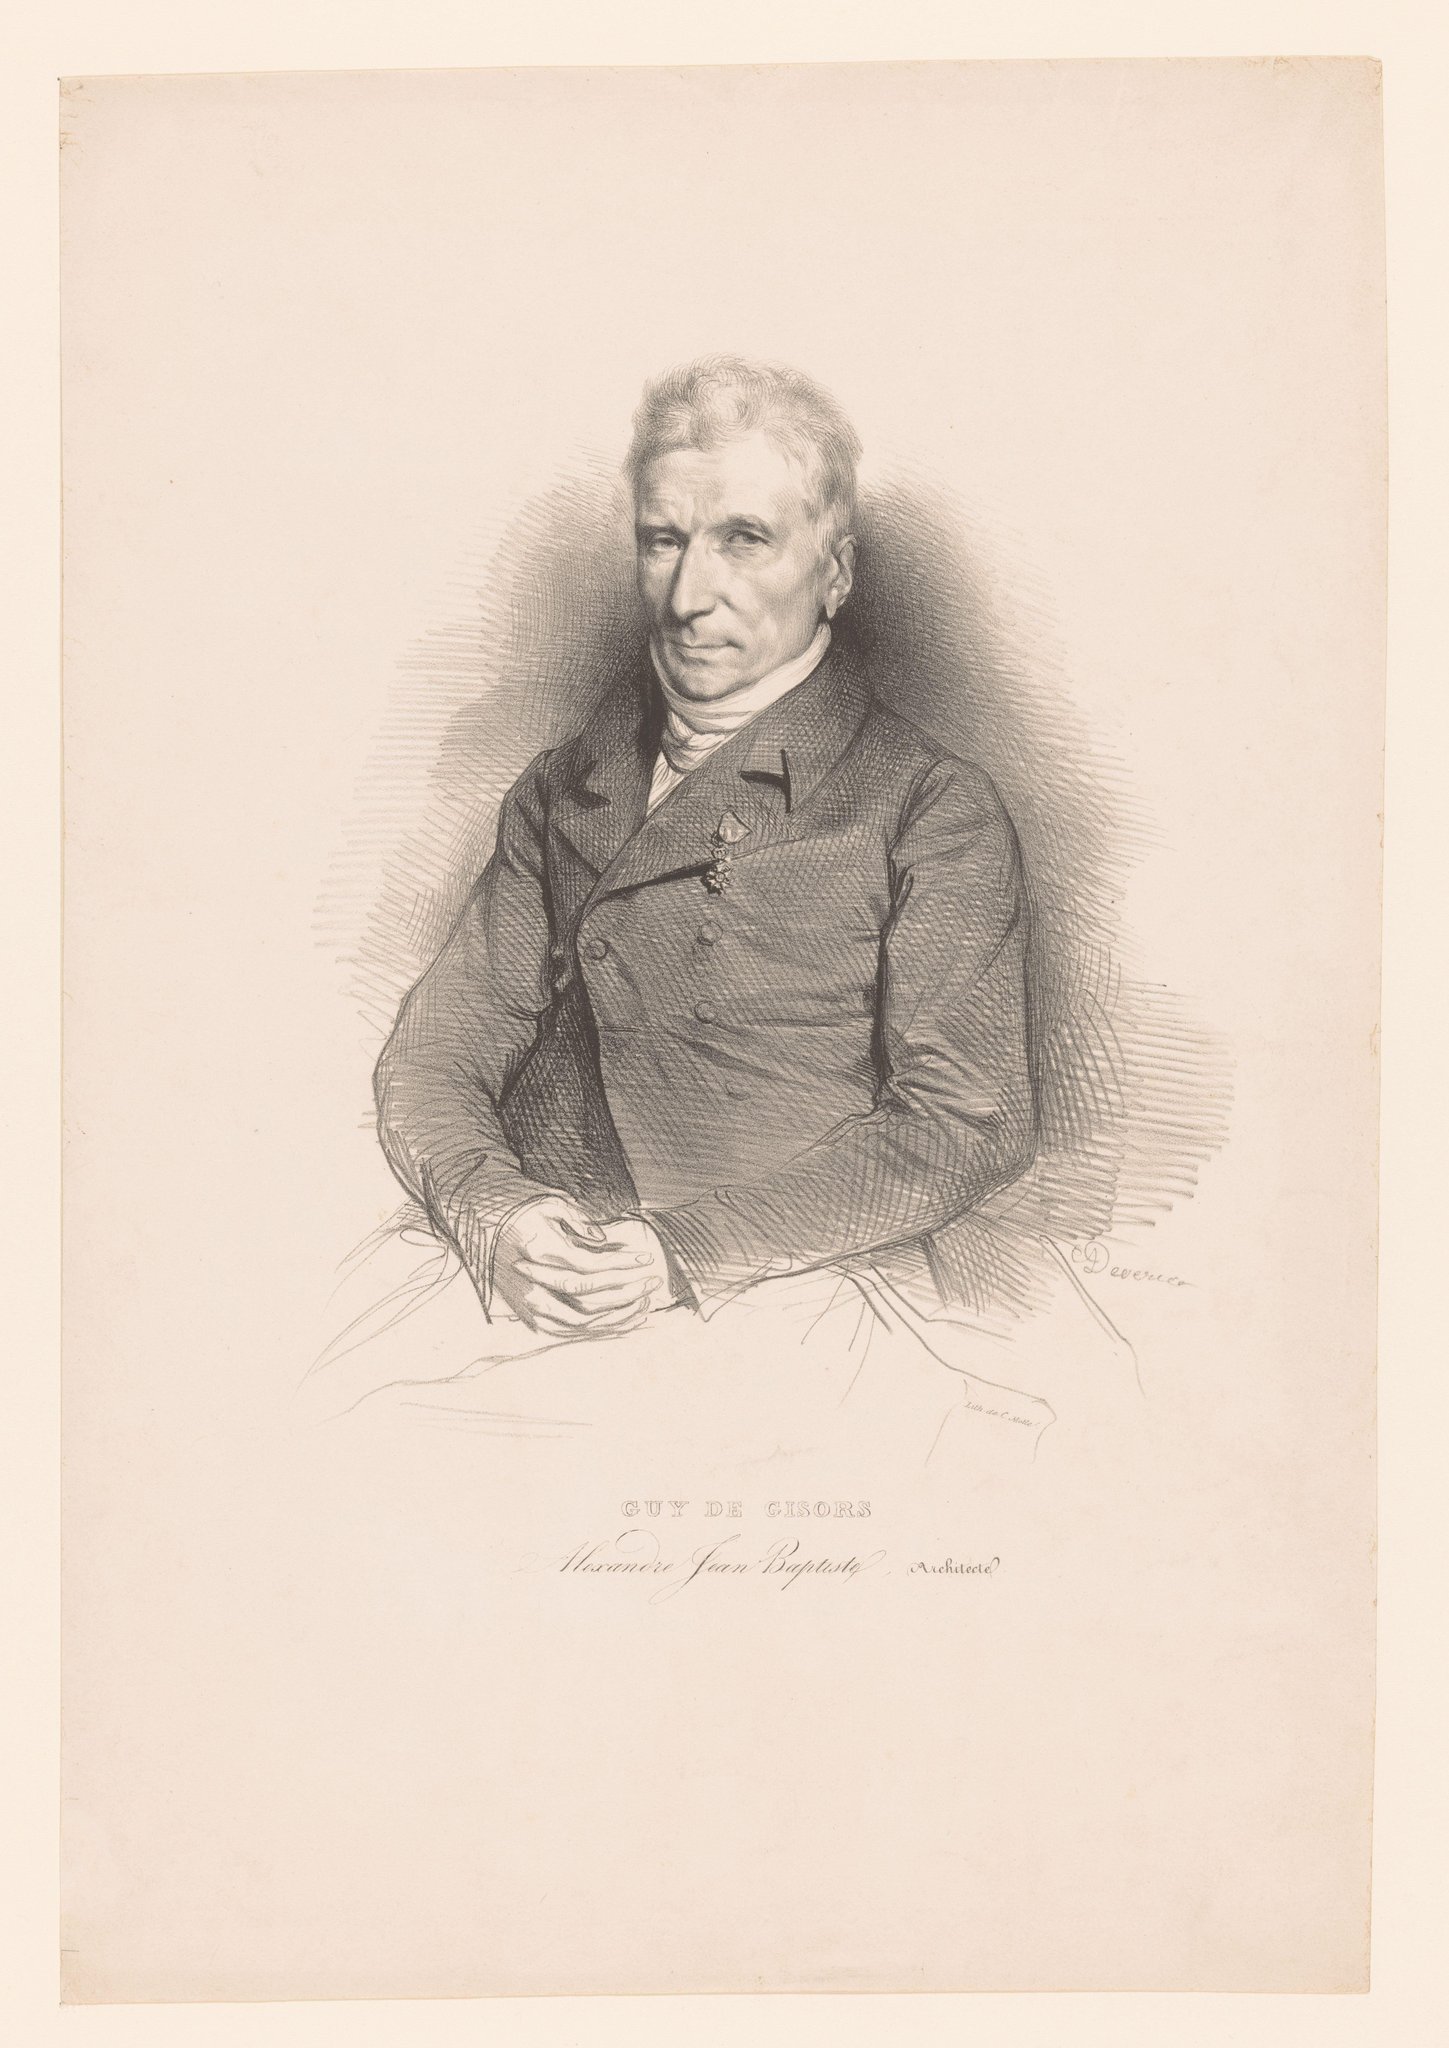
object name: print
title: Portret van Alexandre-Jean-Baptiste-Guy de Gisors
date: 1833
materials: paper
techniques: lithograph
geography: paris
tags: paris, historical persons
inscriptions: collector's mark: Lugt 2228a